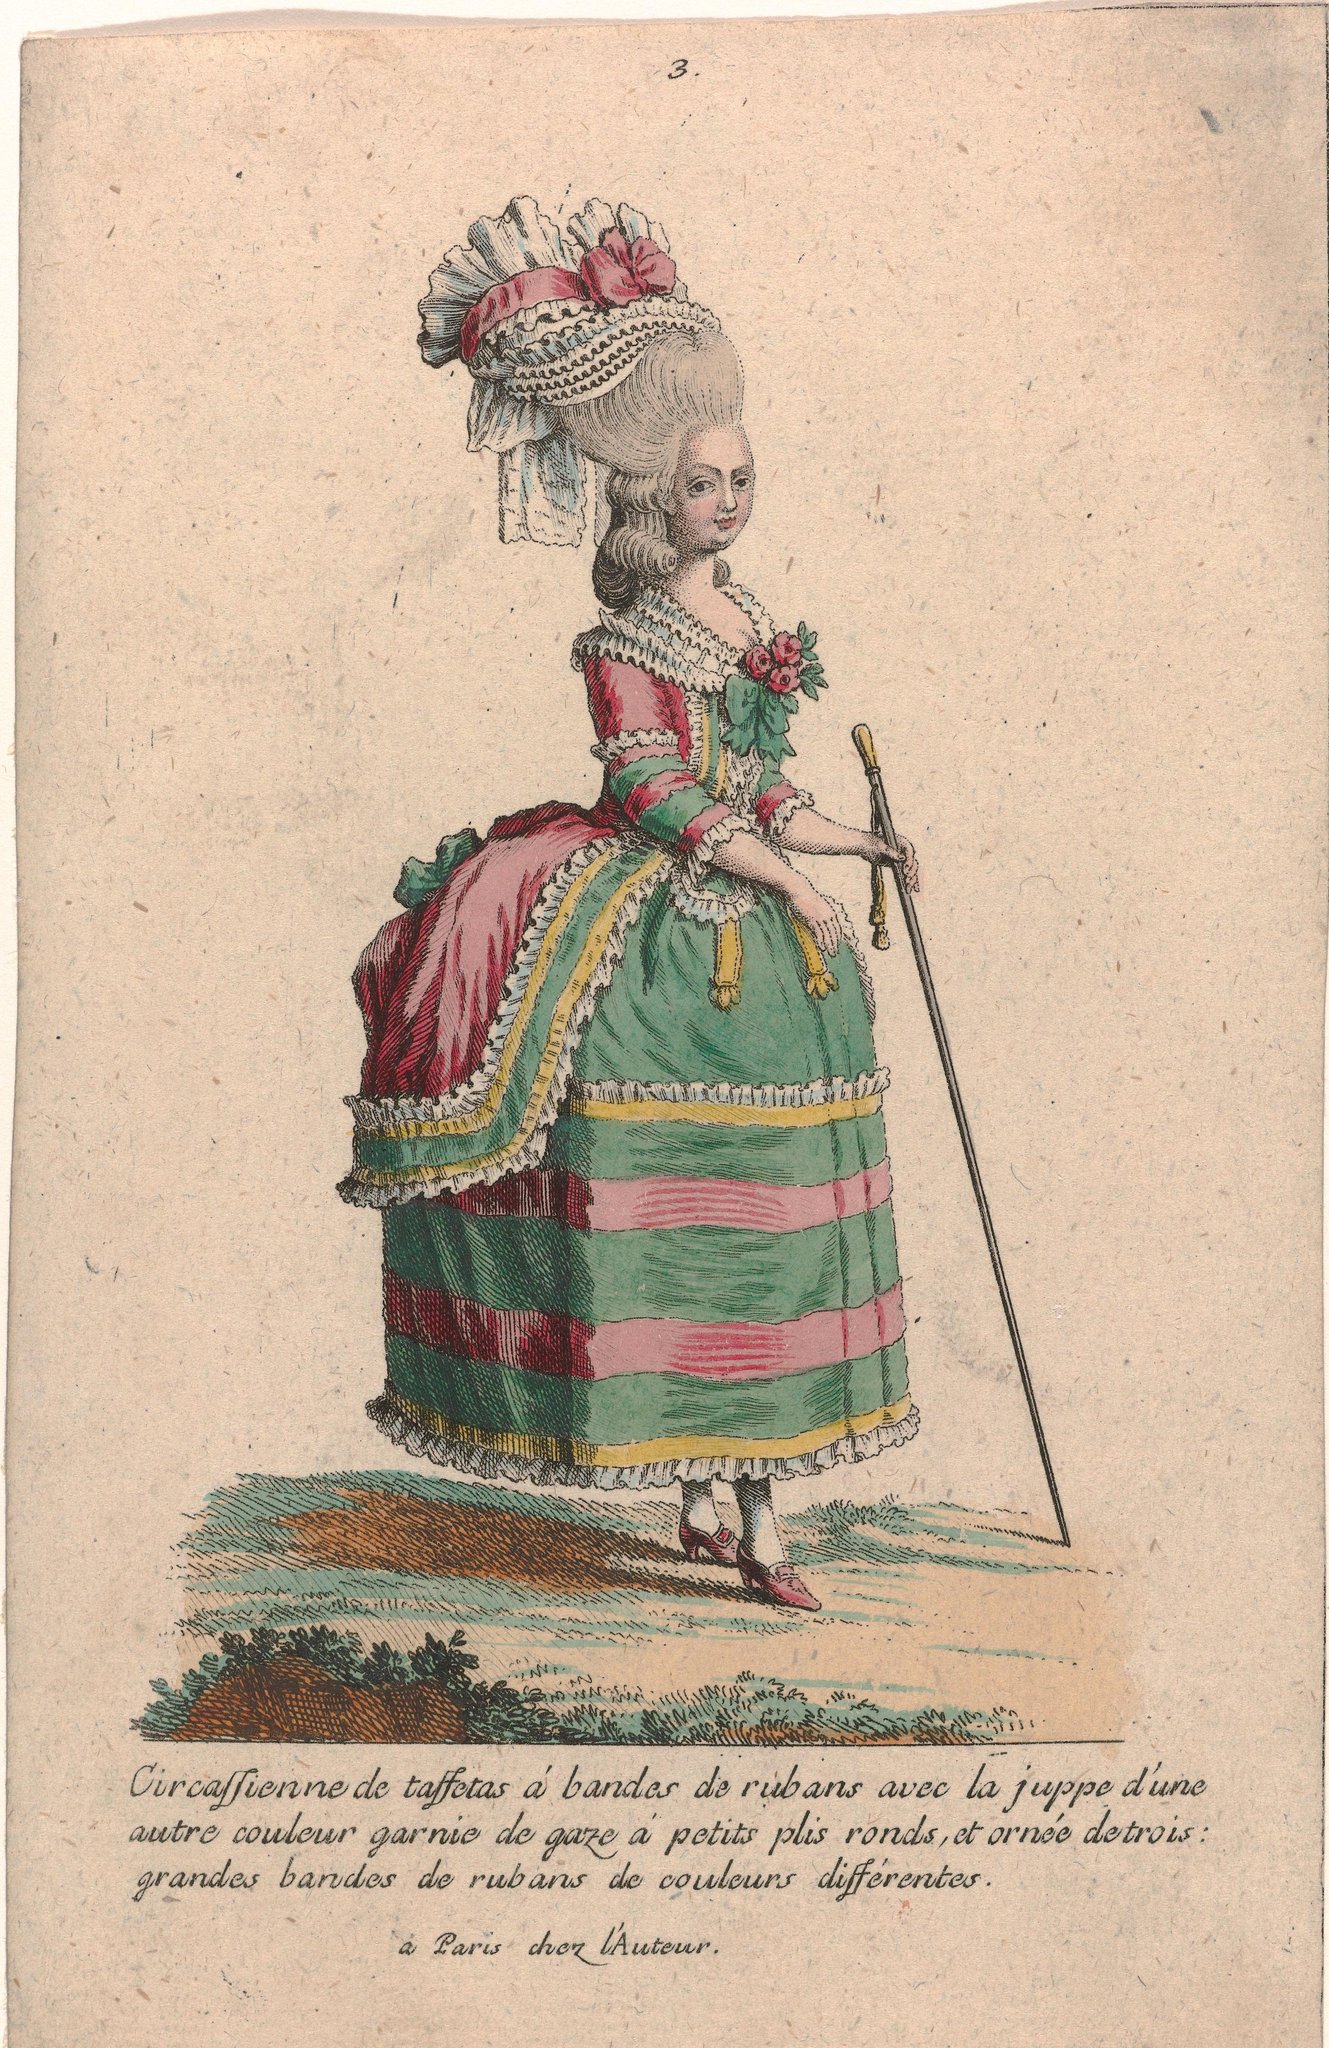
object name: fashion print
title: Gallerie des Modes et Costumes Français, 1785, nr. 3, Kopie naar V 126 : Circassienne de taffetas (...)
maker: pierre gleich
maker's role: print maker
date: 1785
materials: paper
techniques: engraving, hand coloring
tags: corsage (+ women's clothes), flowers, walking-stick, staff, cane (+ women's clothes), border, ribbon, braid (+ women's clothes), dress, gown: robe à la circassienne (+ women's clothes), head-gear: cap (+ women's clothes), fashion plates, shoes, sandals (+ women's clothes), skirt (+ women's clothes), neck-gear ~ clothing (+ women's clothes)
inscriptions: inscription: ‘a Paris chez l'Auteur.’, caption: ‘Circassienne de taffetas a bandes de rubans avec la juppe d'une autre couleur garnie de gaze á petits plis ronds, et ornée de trois : grandes bandes de rubans de couleurs différentes.’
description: Vrouw gekleed in een 'circassienne' van tafzijde met banden van lint. Rok van een andere kleur versierd met geplooide tule en drie grote banden van lint in verschillende kleuren. Accessoires: geplooide muts versierd met lint, bloemcorsage, wandelstok met kwasten, chatelaines, schoenen met hakken en gespen. Kopie naar V 126 uit serie V. 21e Cahier des Costumes Français, 15e Suite d'Habillemens à la mode en 1779, Gallerie des Modes et Costumes Français.